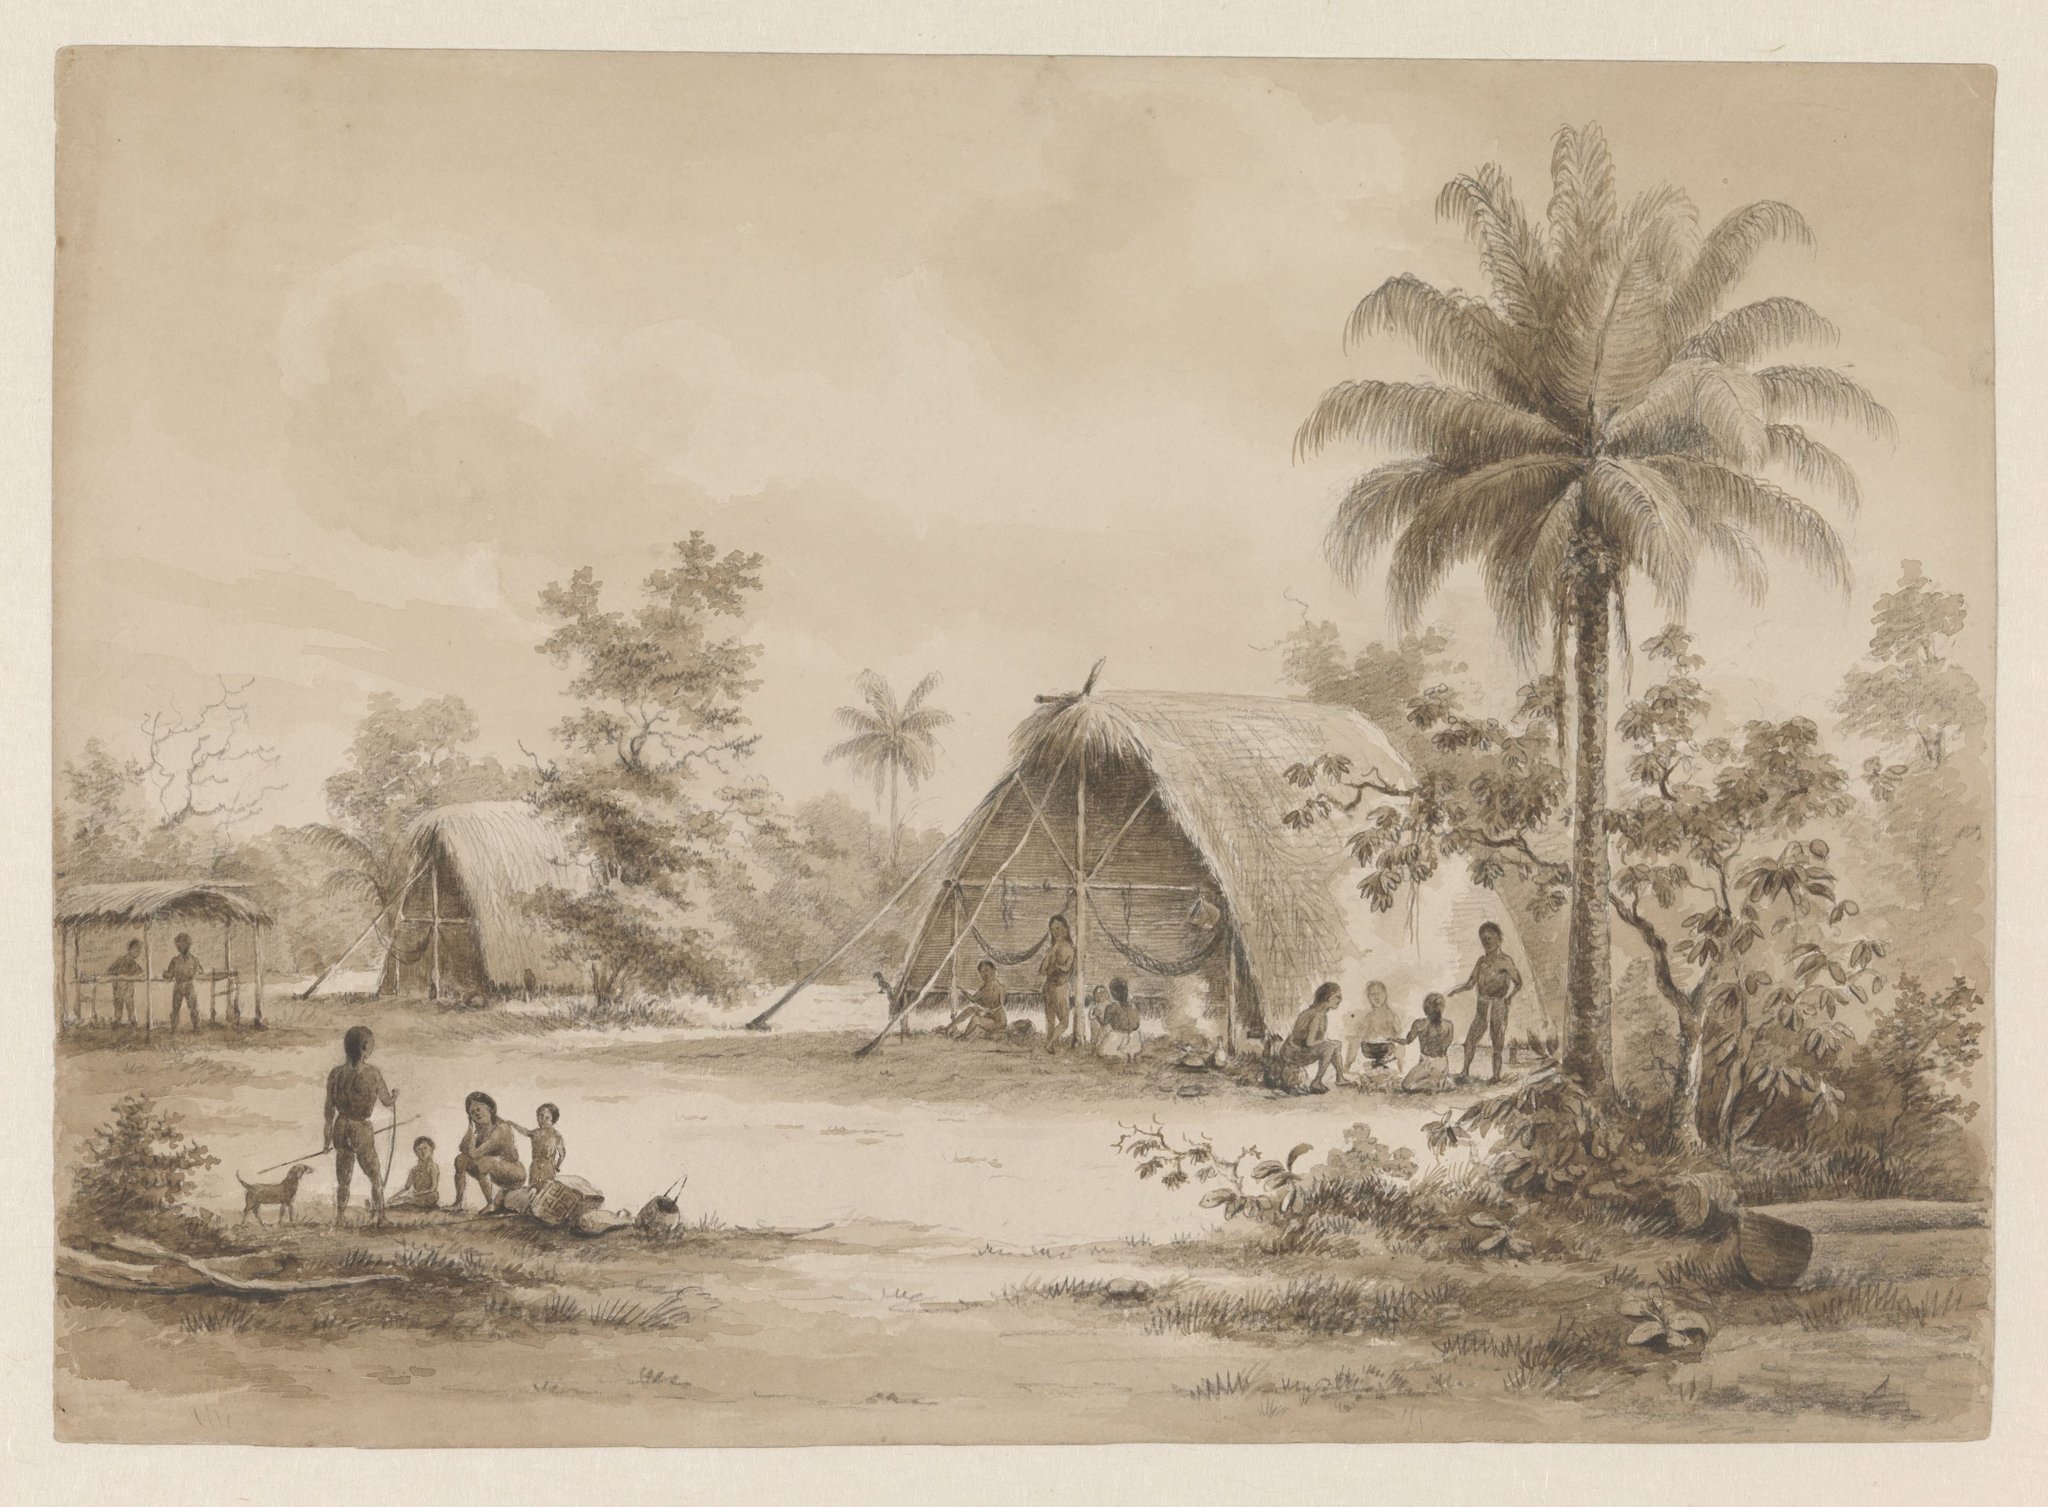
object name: drawing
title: Kamp van de Arowakken of Caraïben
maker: hendrik huygens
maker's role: amateurtekenaar, officier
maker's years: 1810-1867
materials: paper, pencil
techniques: brush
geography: paramaribo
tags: landscapes in tropical and sub-tropical regions, suriname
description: Bij dit kamp van de Arowakken of Caraïben zijn de hutten heel eenvoudig en dienen voornamelijk als beschutting tegen zon en regen. Het dak van bladeren reikt tot aan de grond. De vloer is de witte zandgrond van de savanne. In de hutten hangen hangmatten. Er is een kookplek naast een van de hutten. Het is niet duidelijk of Huygens hier leden van de stam van de Arowakken of de Caraïben heeft getekend. Beiden horen tot de bevolkingsgroepen die leven aan de benedenloop van de rivieren, in de kuststreek van Suriname. Omdat deze bevolkingsgroepen van oorsprong nomaden zijn, worden hun dorpen ook wel kamp, of kampement genoemd.